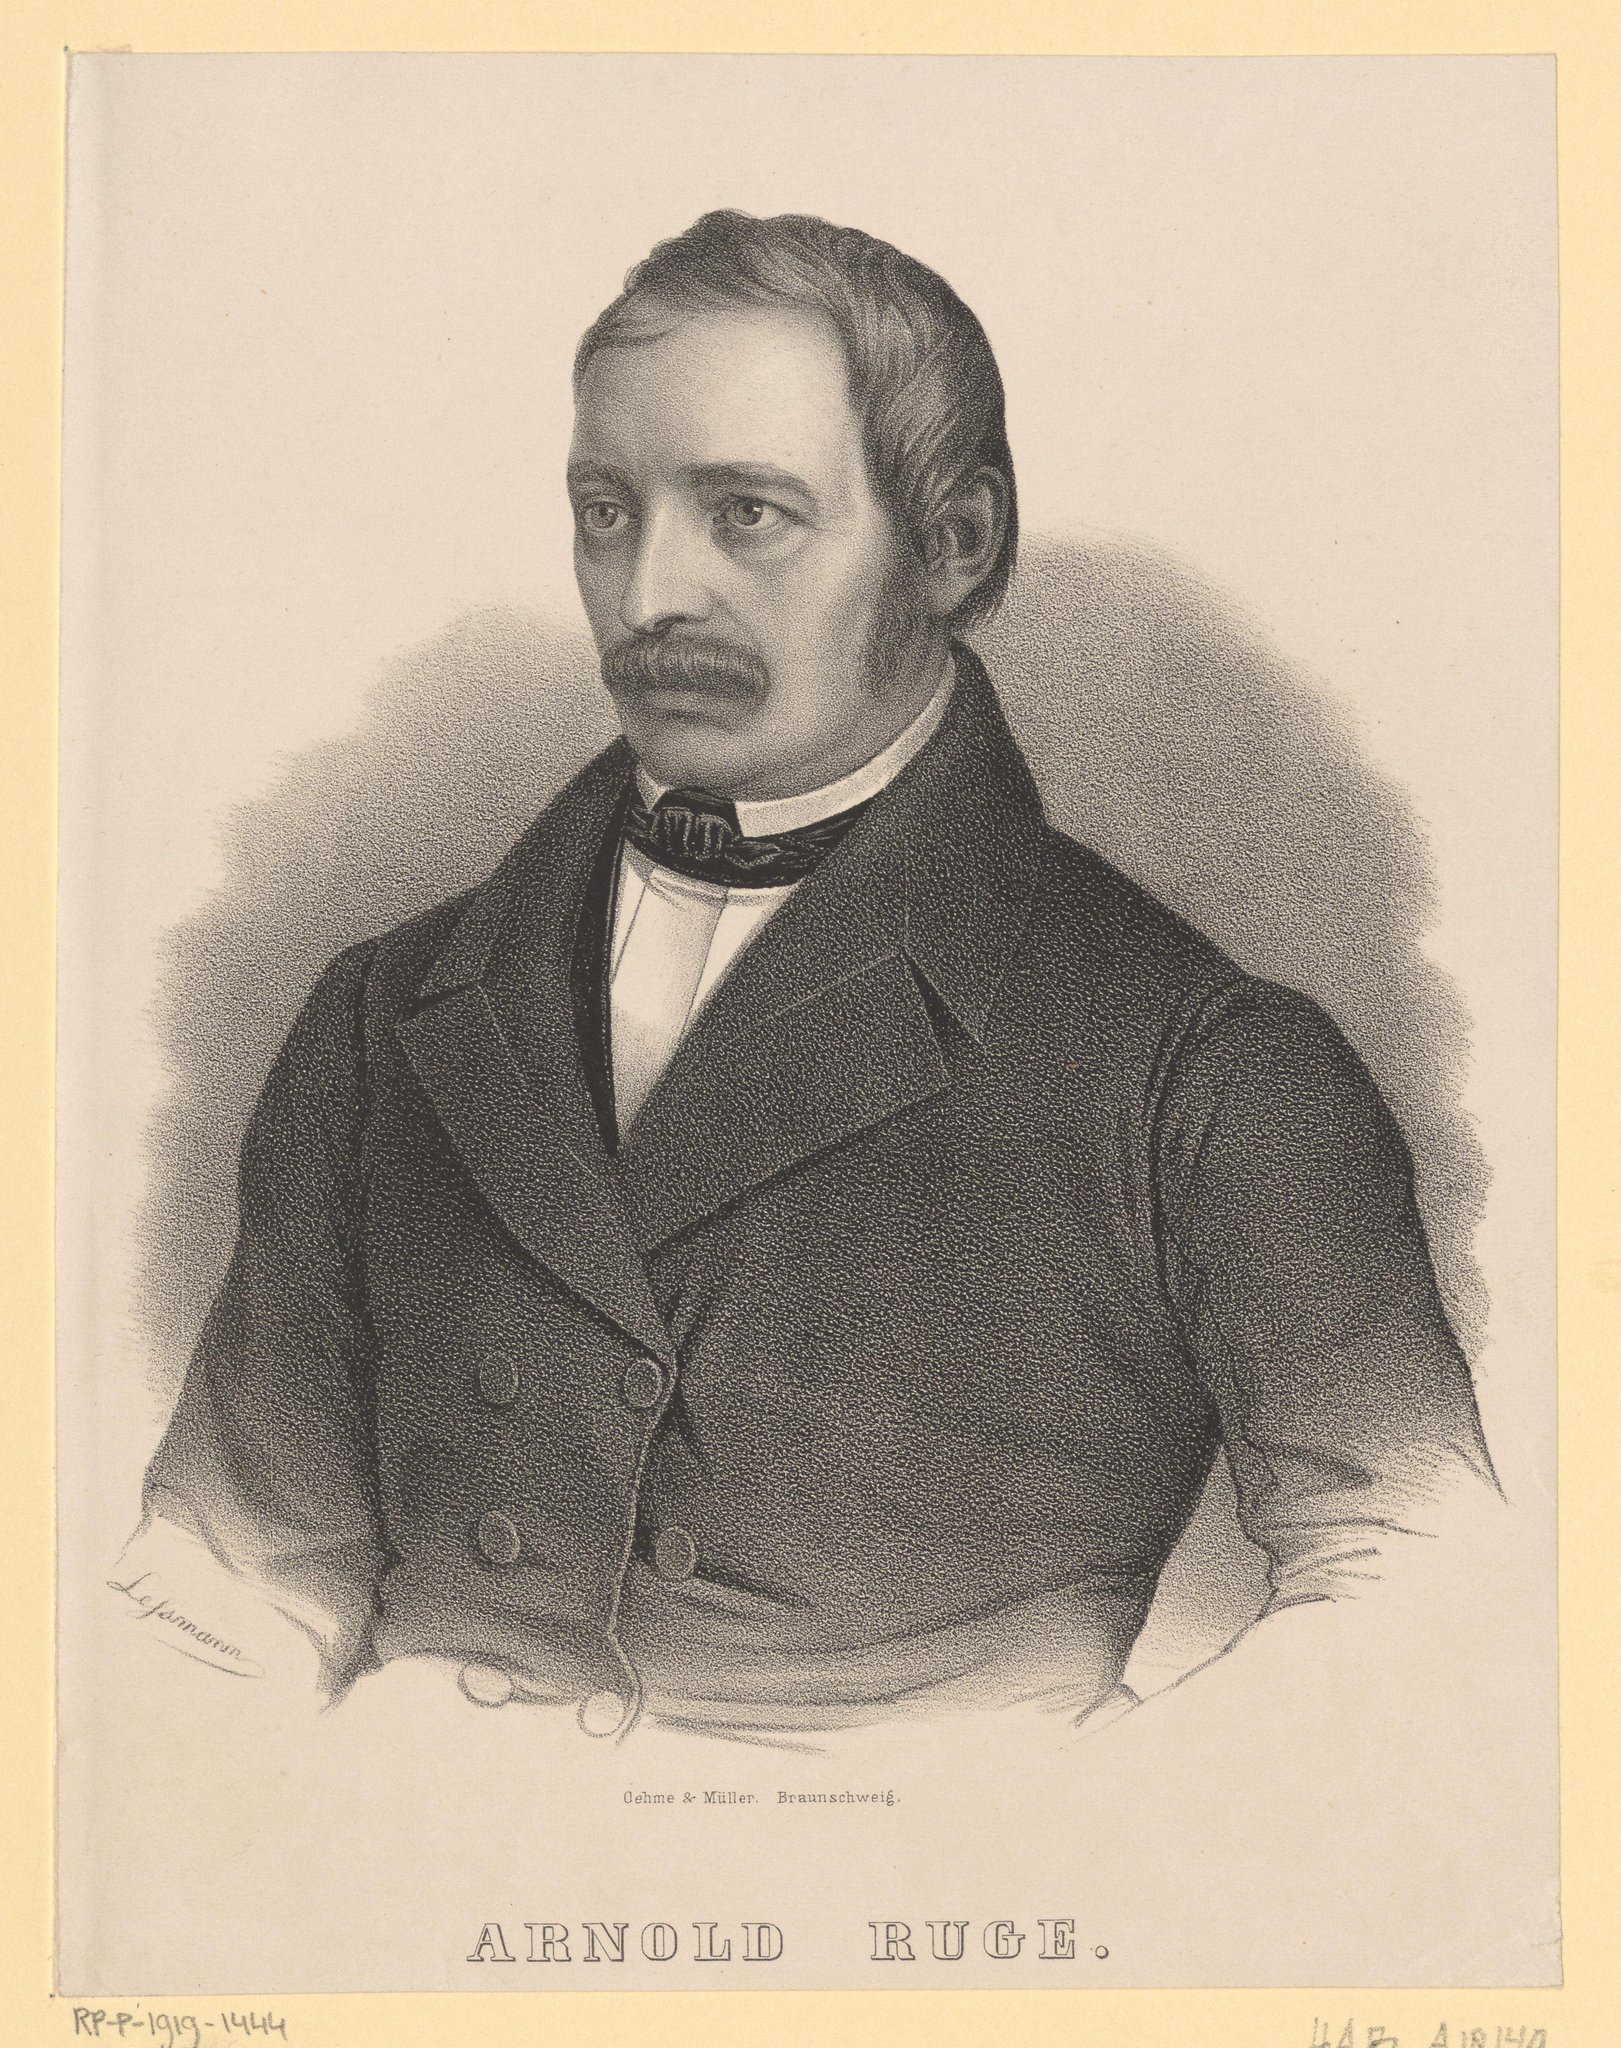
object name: print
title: Portret van Arnold Ruge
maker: lessmann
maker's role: print maker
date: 1825-1846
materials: paper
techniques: lithograph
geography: braunschweig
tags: historical persons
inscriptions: collector's mark: Lugt 2228